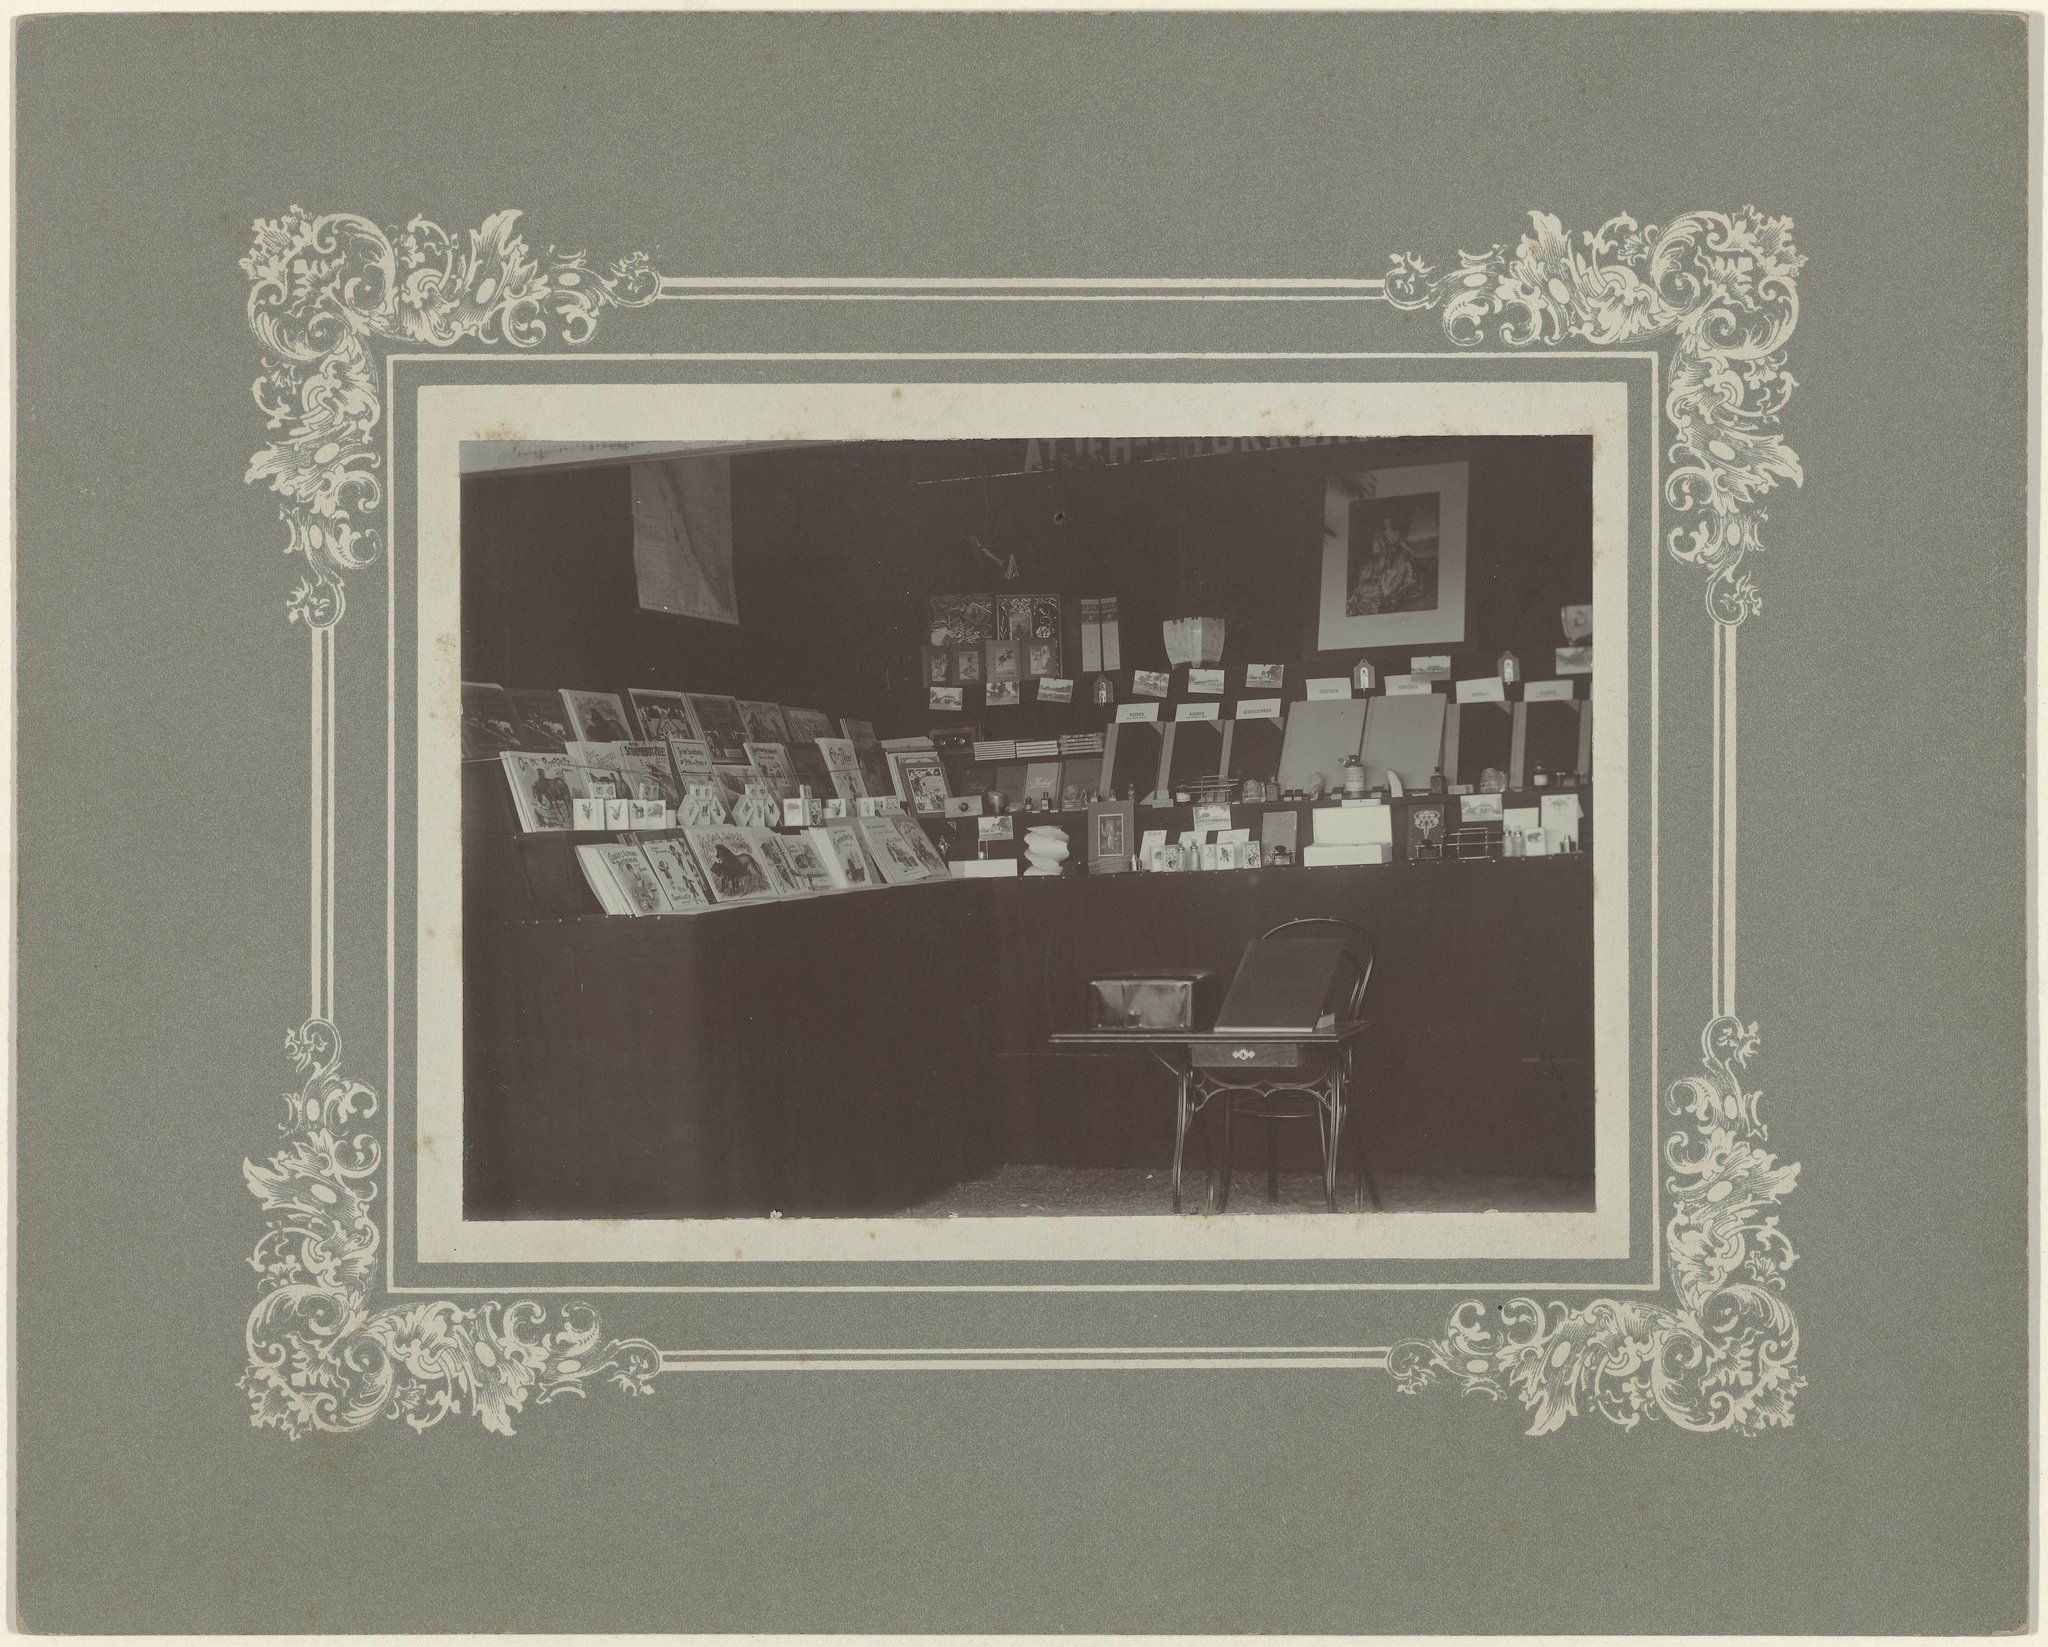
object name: photograph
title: Tentoonstelling door Atjeh Drukkerij te Koeta-Radja in 1911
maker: Anonymous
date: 1905-1911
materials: cardboard, photographic support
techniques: collodion silver print, gelatin silver print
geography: banda atjeh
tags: dutch east indies, the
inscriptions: inscription: ‘Tentoonstelling Koeta Radja / mei 1911.’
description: Tentoonstelling van drukwerk vervaardigd door de Atjeh Drukkerij te Koeta-Radja (Banda Atjeh) in mei 1911. Uitstalling van kinderboeken, atlassen, foto's, prentbriefkaart, prenten, prentenboeken en artikelen uit de kantoorboekhandel, vooraan een tafeltje met een schrijfmachine. Foto opgeplakt binnen decoratieve omlijsting. Onderdeel van een groep van negen foto's over de Atjeh-drukkerij.